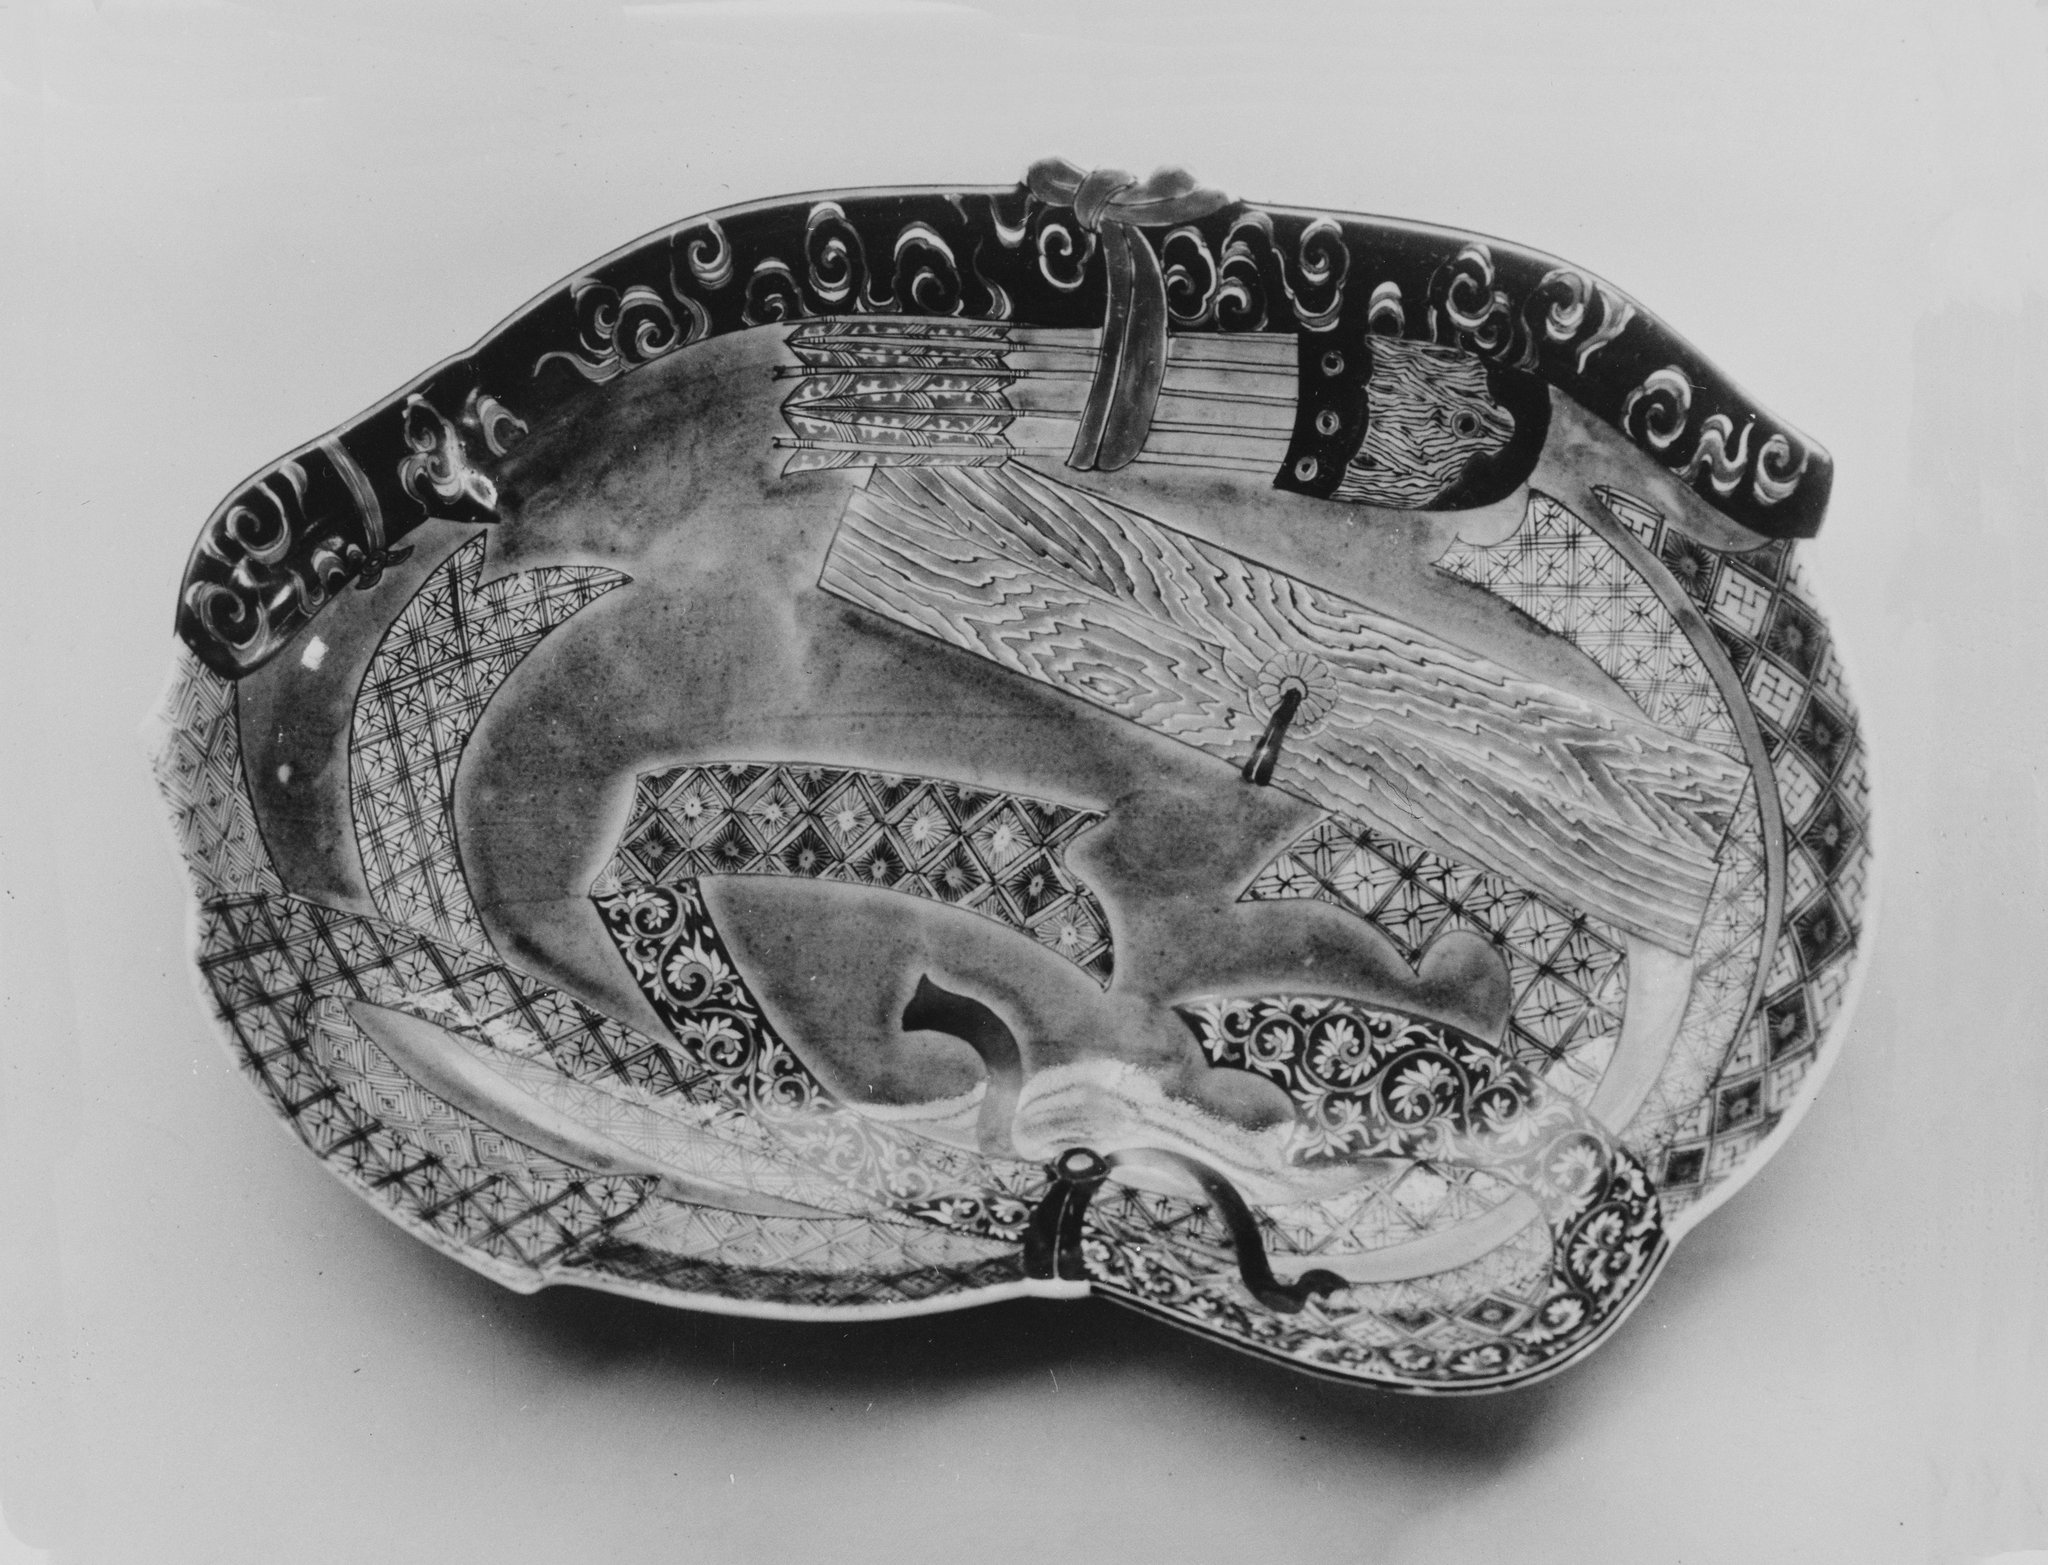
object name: plate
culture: japanese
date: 1720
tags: bow and arrow